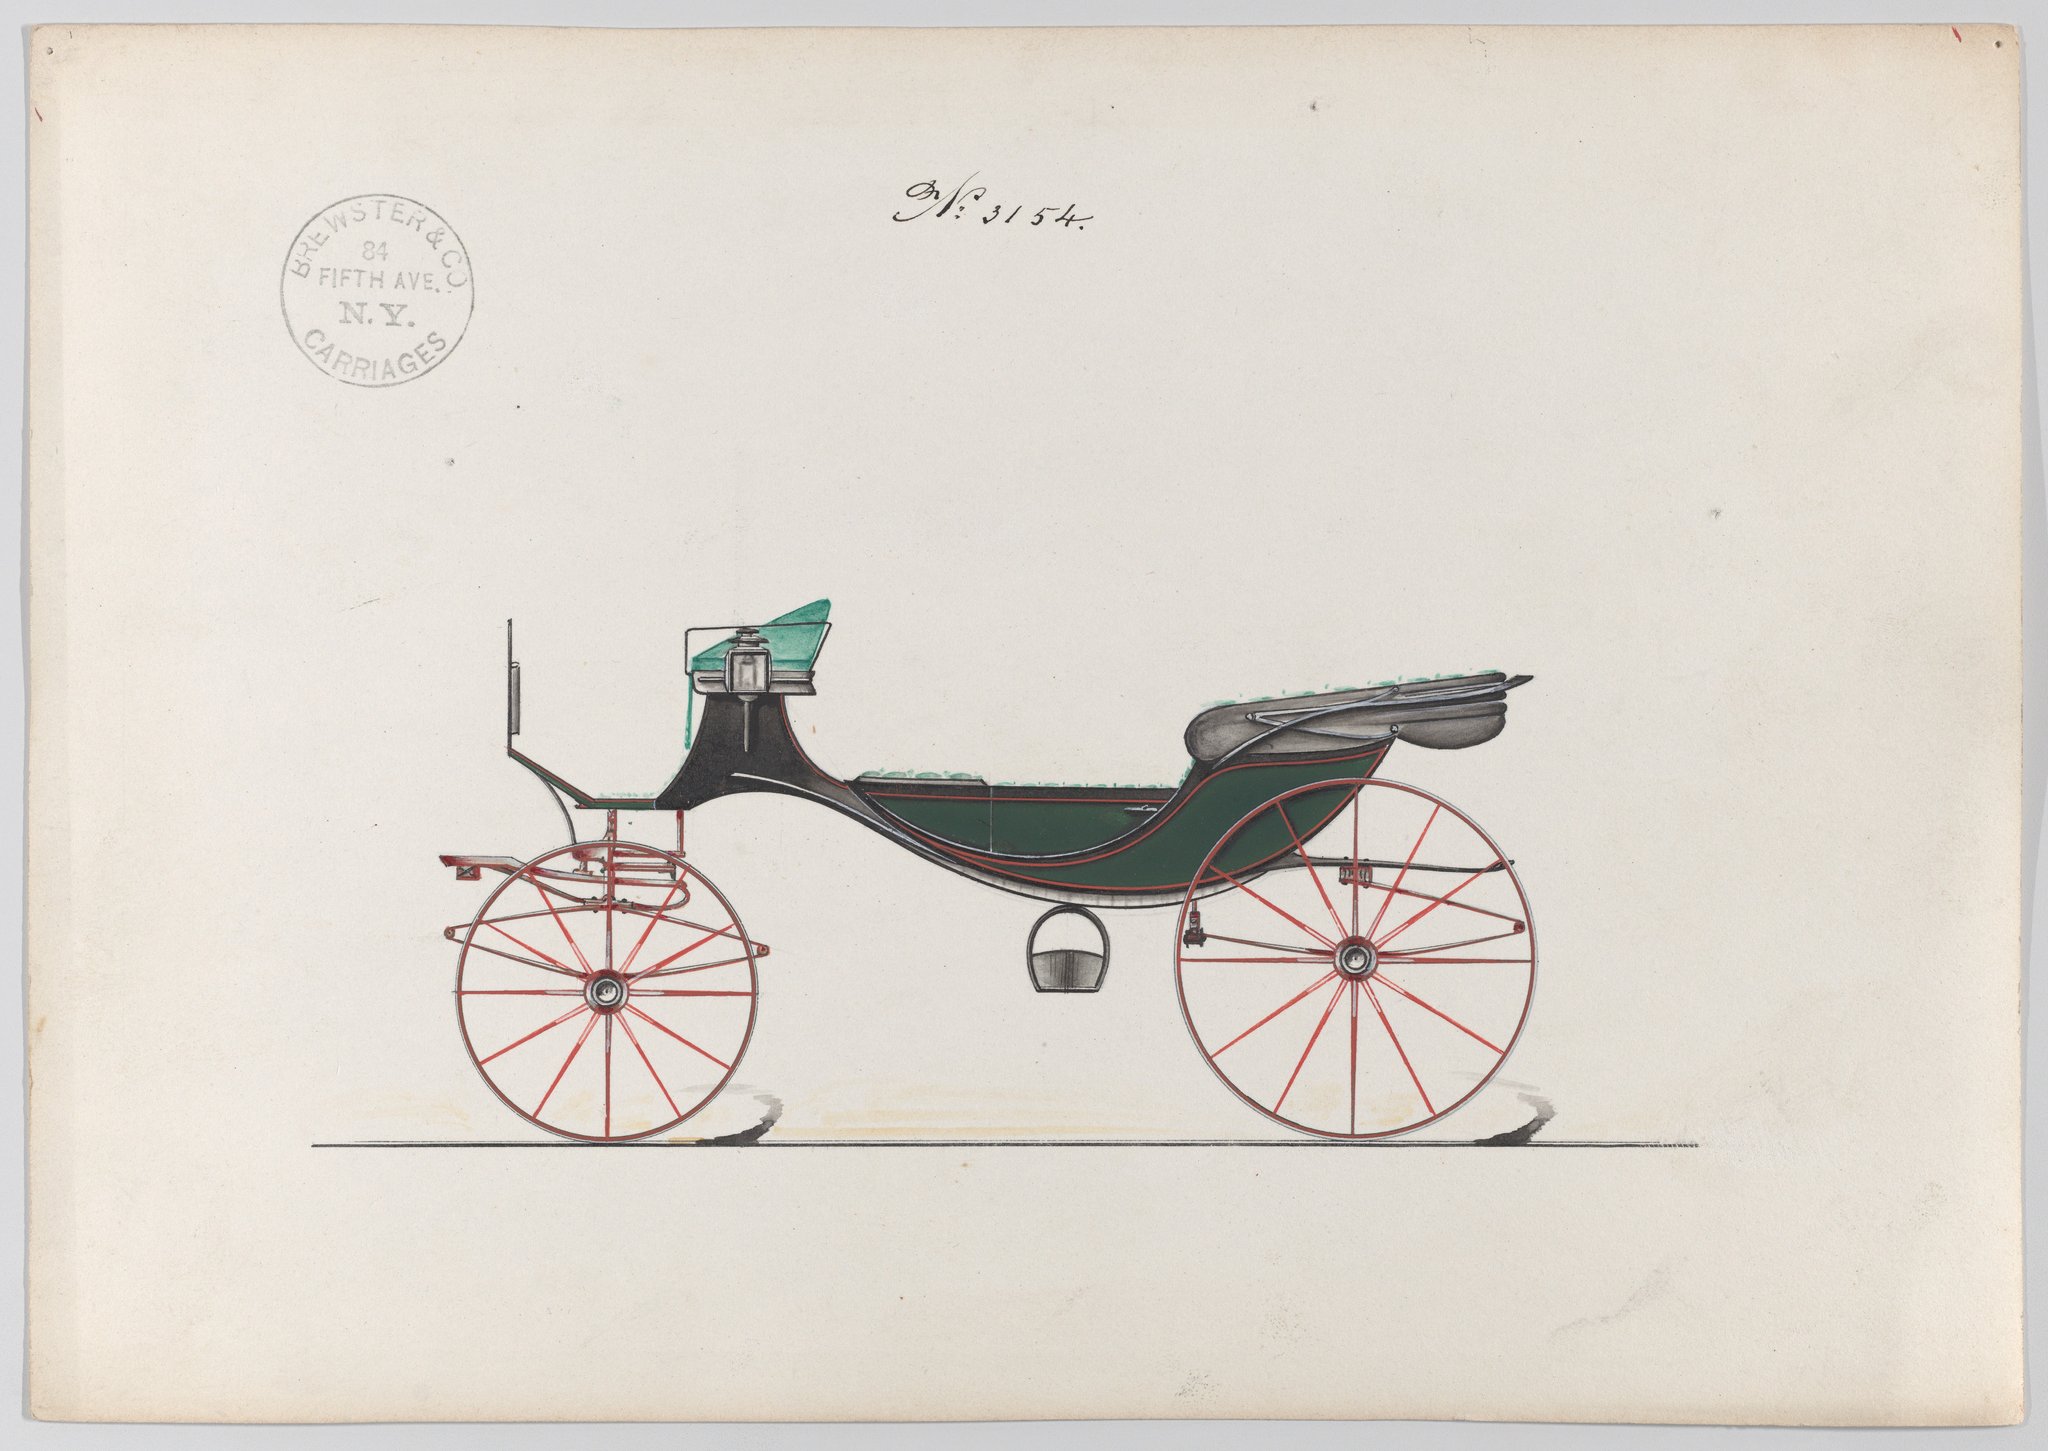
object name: drawing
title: Design for a Caleche or Vis-a-vis, no. 3154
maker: brewster & co.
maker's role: manufacturer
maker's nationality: american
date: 1875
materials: gouache, ink, watercolor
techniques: pen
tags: carriages